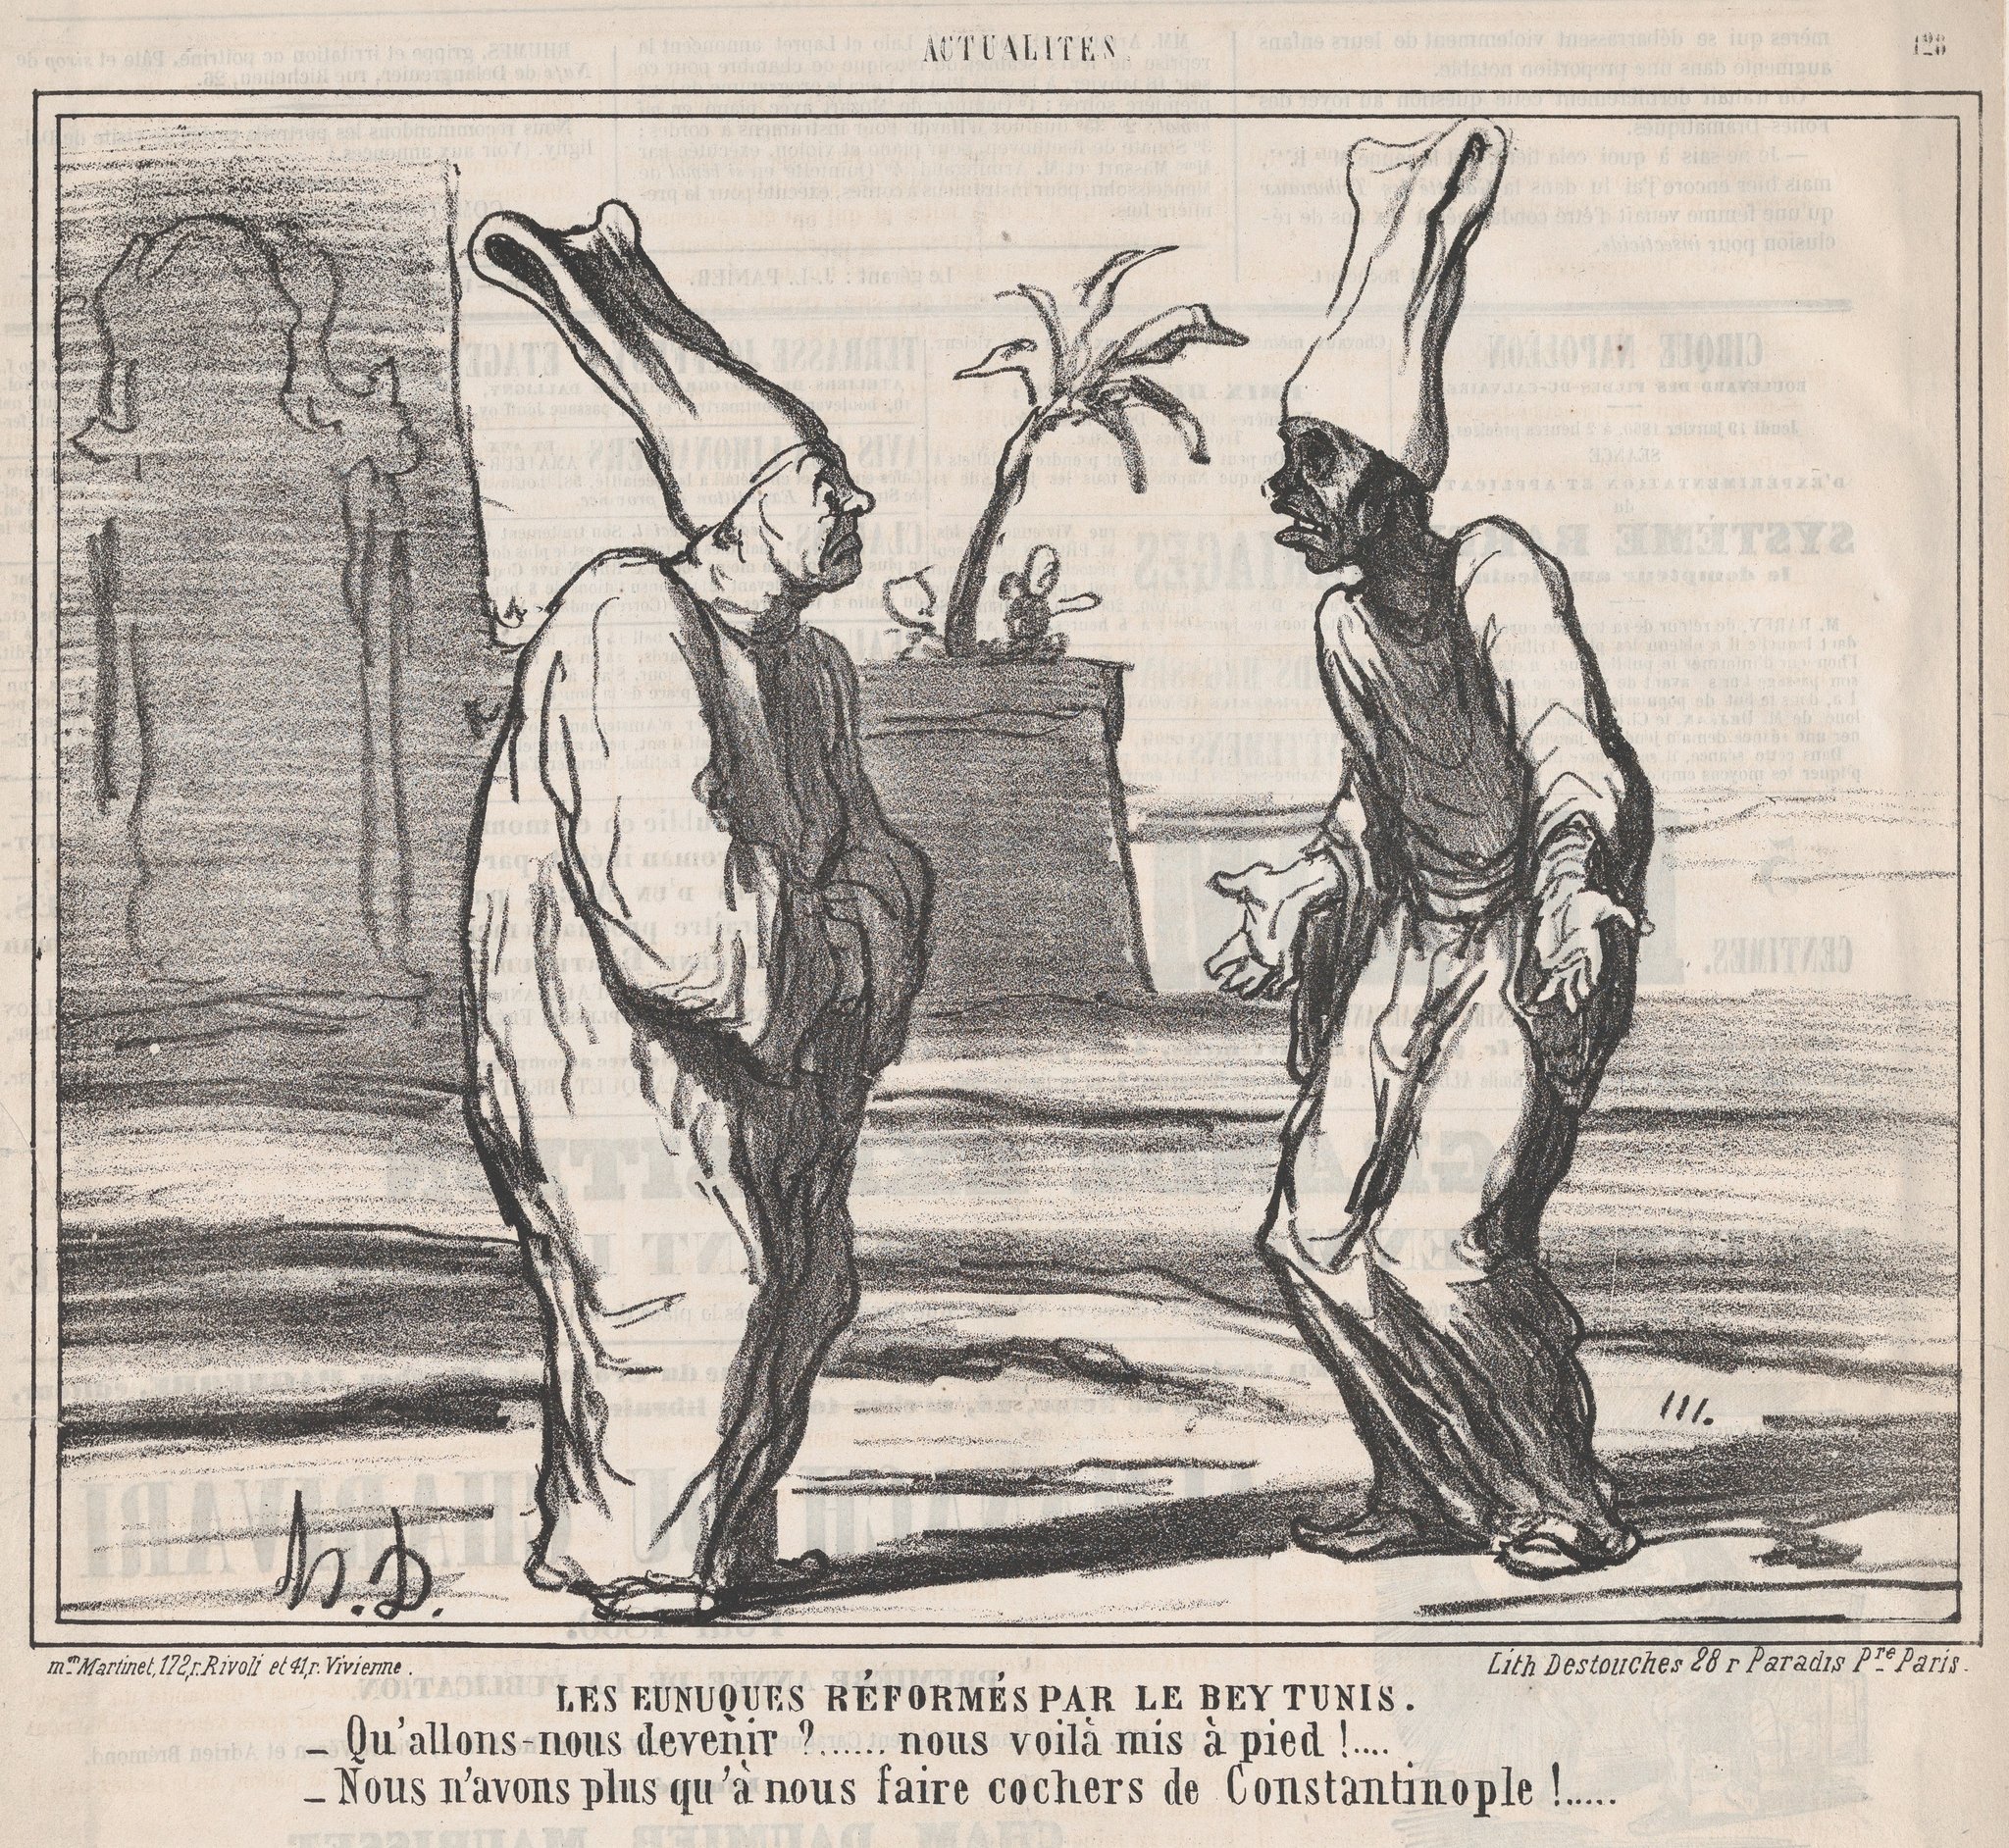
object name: print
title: Eunuchs Reformed by the Bey of Tunis, from "News of the Day"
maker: honoré daumier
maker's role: artist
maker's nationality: french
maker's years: 1808-1879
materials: paper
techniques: lithograph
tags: satire,men